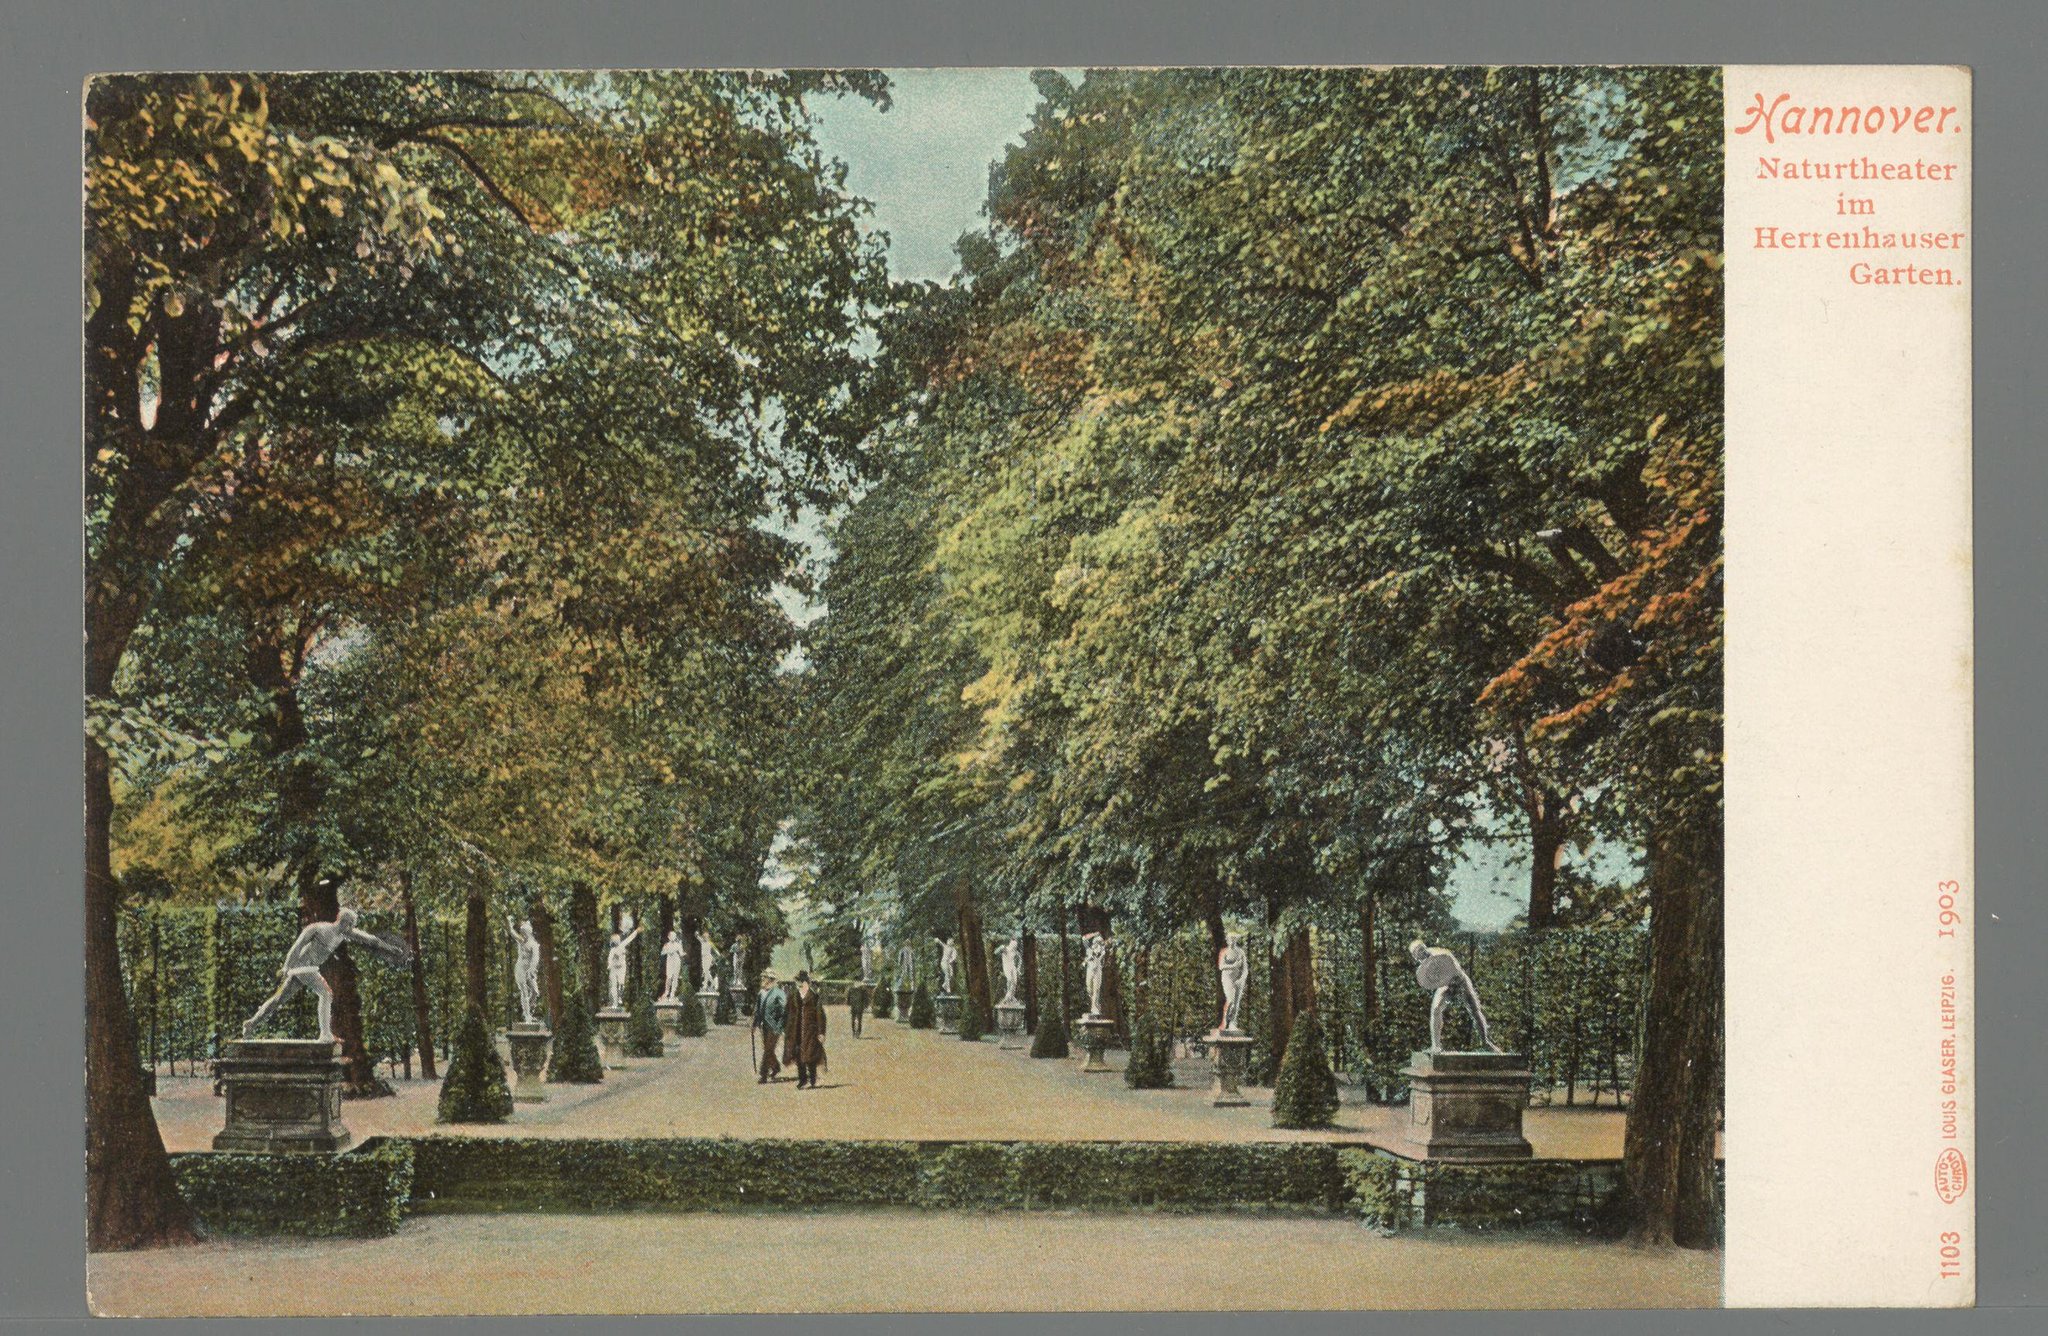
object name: photomechanical print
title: Hannover. Natyrtheater im Herrenhausen Garten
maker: louis glaser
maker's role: printer, publisher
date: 1903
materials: cardboard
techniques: lithograph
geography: leipzig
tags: canals, waters (in city), bridge in city across river, canal, etc., street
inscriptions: date